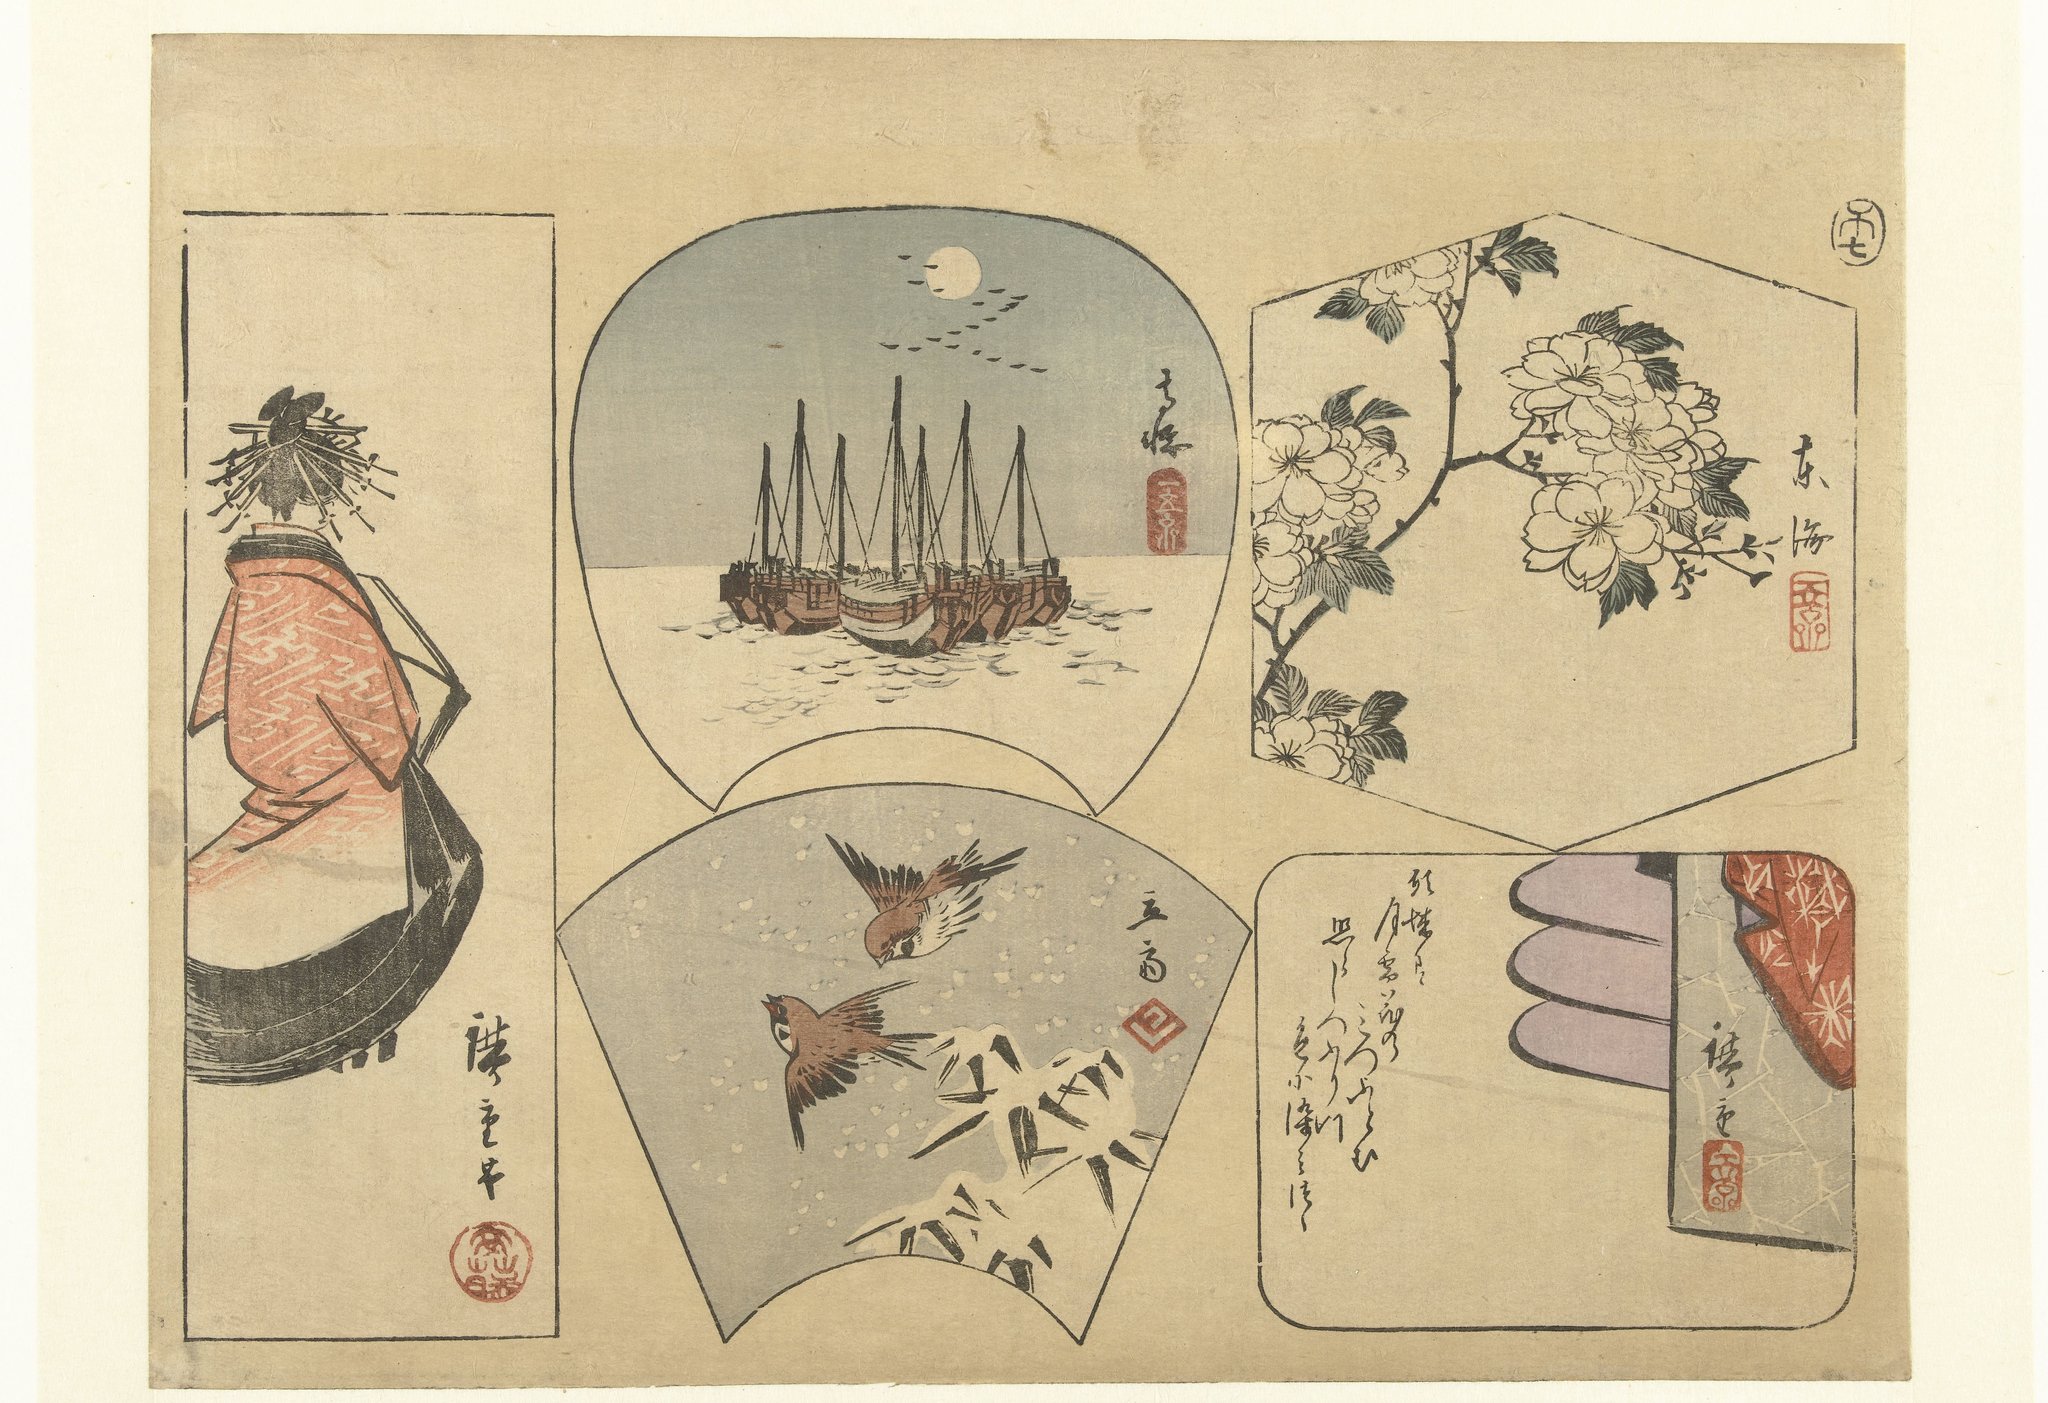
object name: harimaze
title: Vijf uitknipplaatjes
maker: utagawa hiroshige (i)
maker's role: draughtsman, print maker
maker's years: 1797-1858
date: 1858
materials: paper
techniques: woodcut, nishiki e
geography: tokyo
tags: flowers, birds, traffic on the water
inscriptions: date